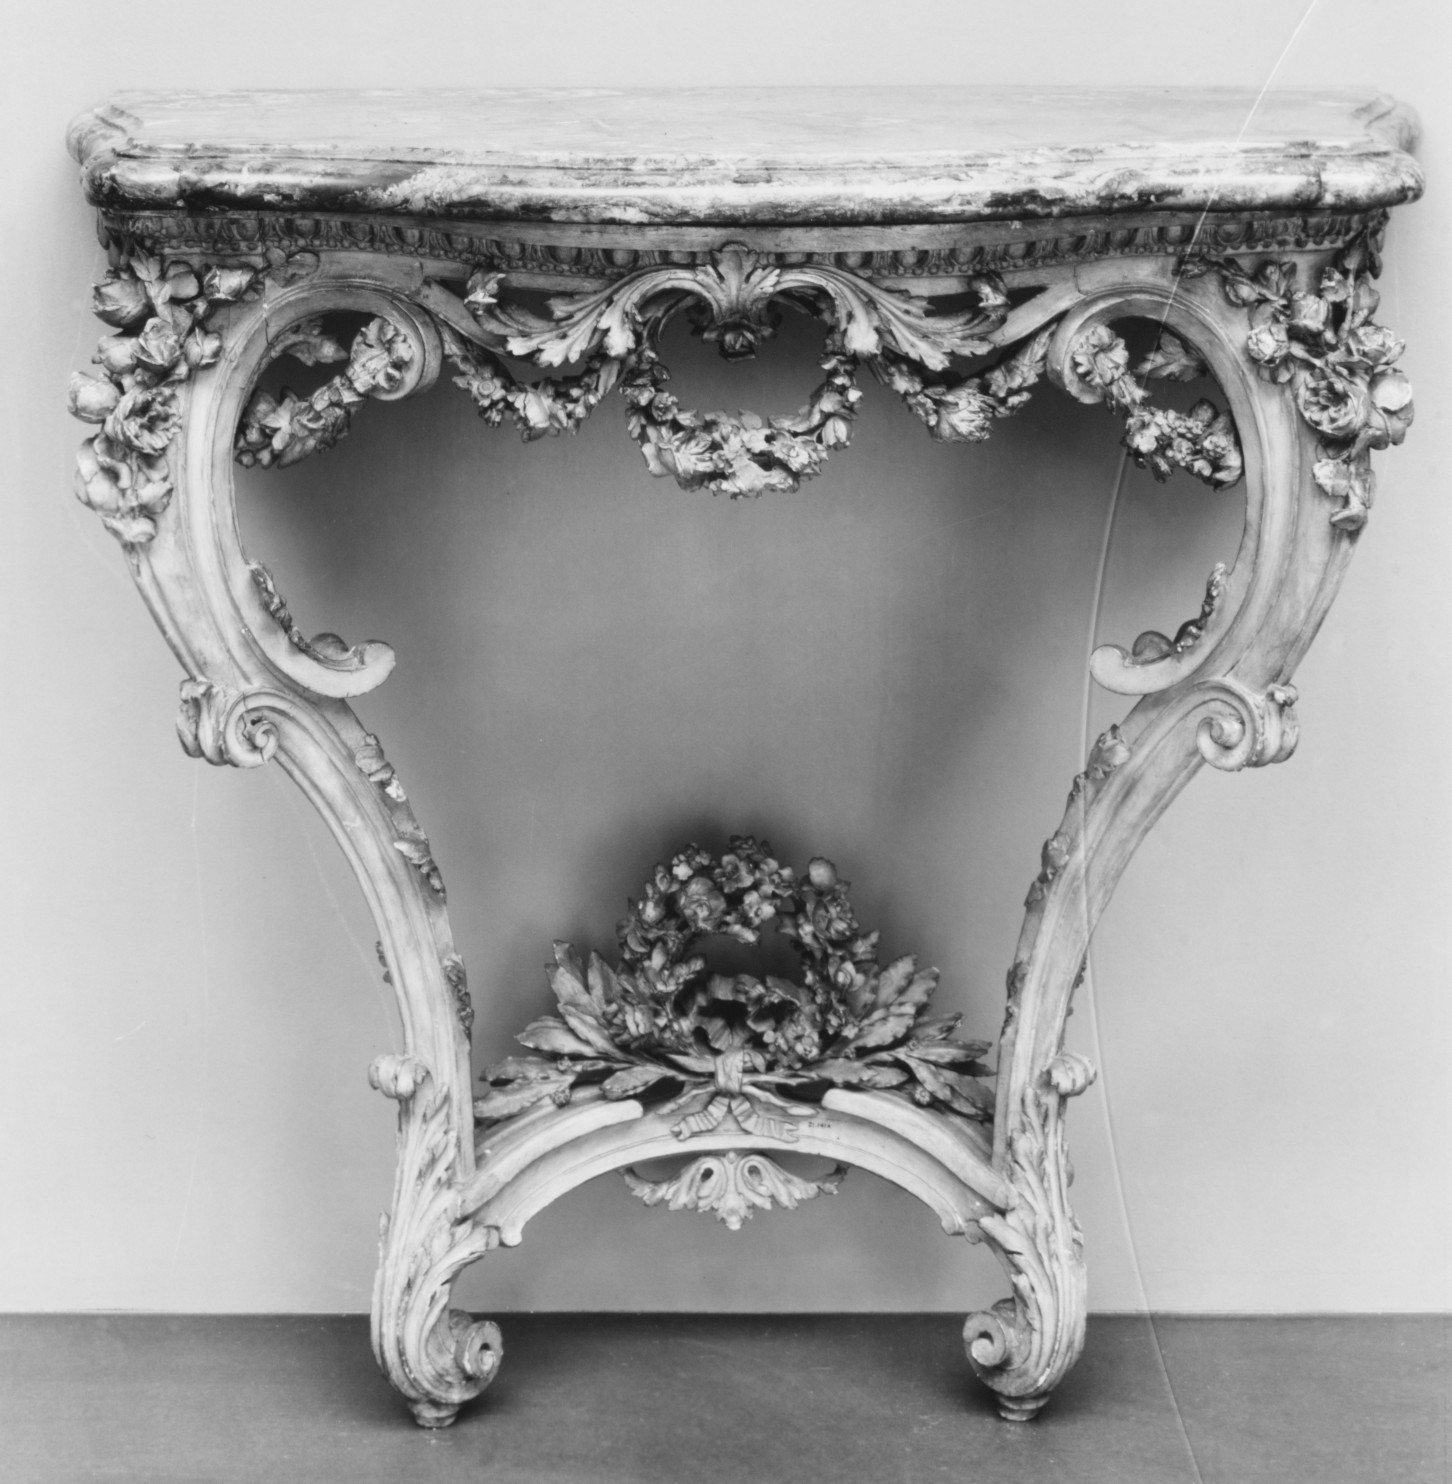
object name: console table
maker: jean-baptiste joseph delafosse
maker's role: maker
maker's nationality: french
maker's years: 1721-1806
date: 1760-1770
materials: marble, wood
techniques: carving, painting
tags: garlands,flowers